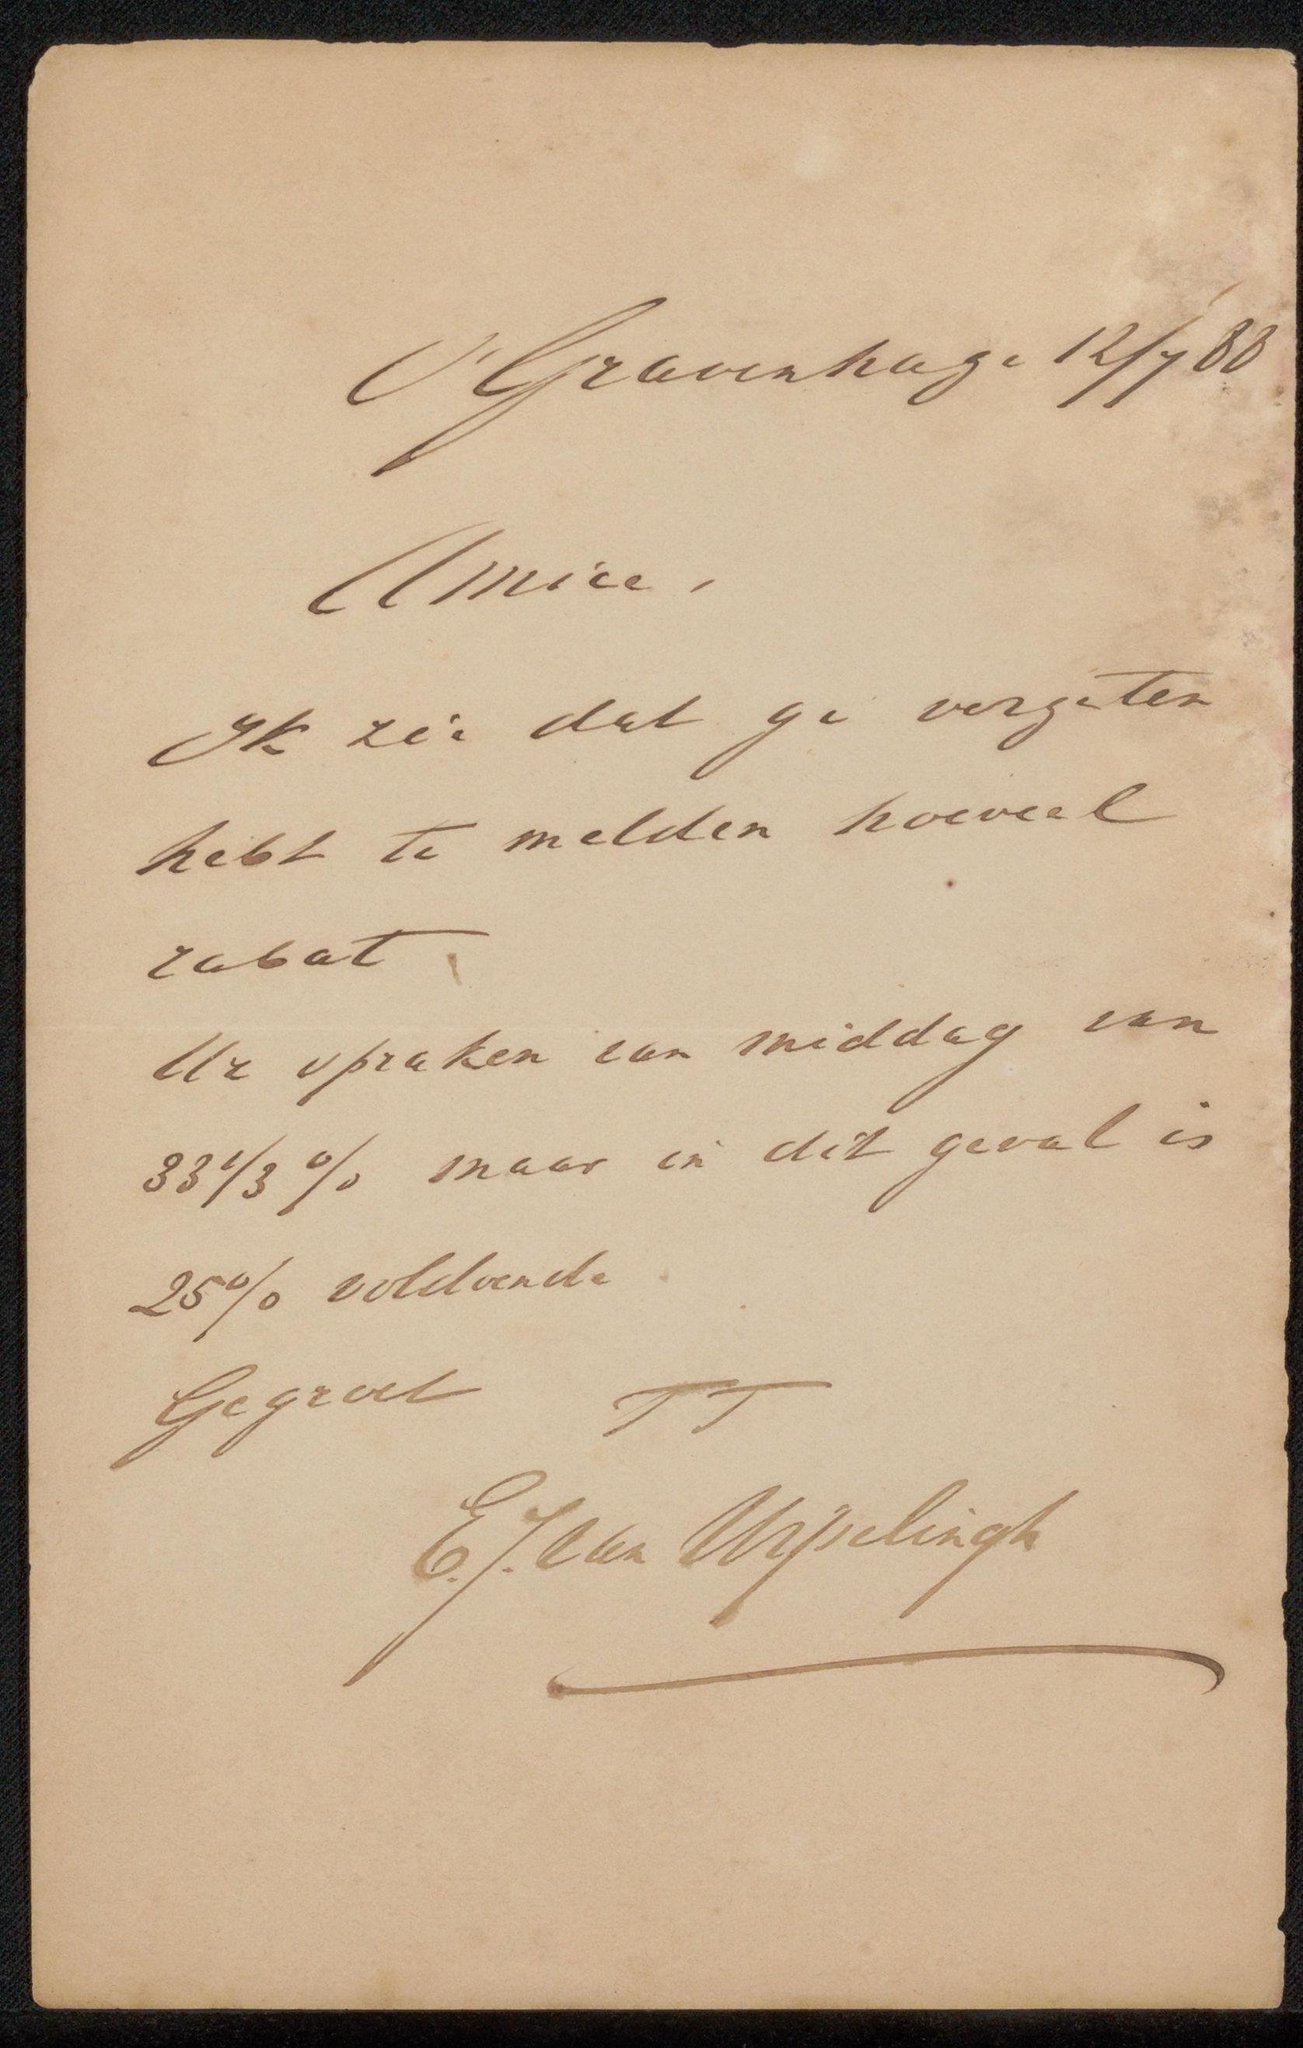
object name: letter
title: Brief aan Philip Zilcken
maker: elbert jan van wisselingh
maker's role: kunsthandelaar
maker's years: 1848-1912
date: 1888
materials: ink, paper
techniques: pen, writing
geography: the hague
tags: the hague, painter, draughtsman, philip zilcken, money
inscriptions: collector's mark: ‘RPK’